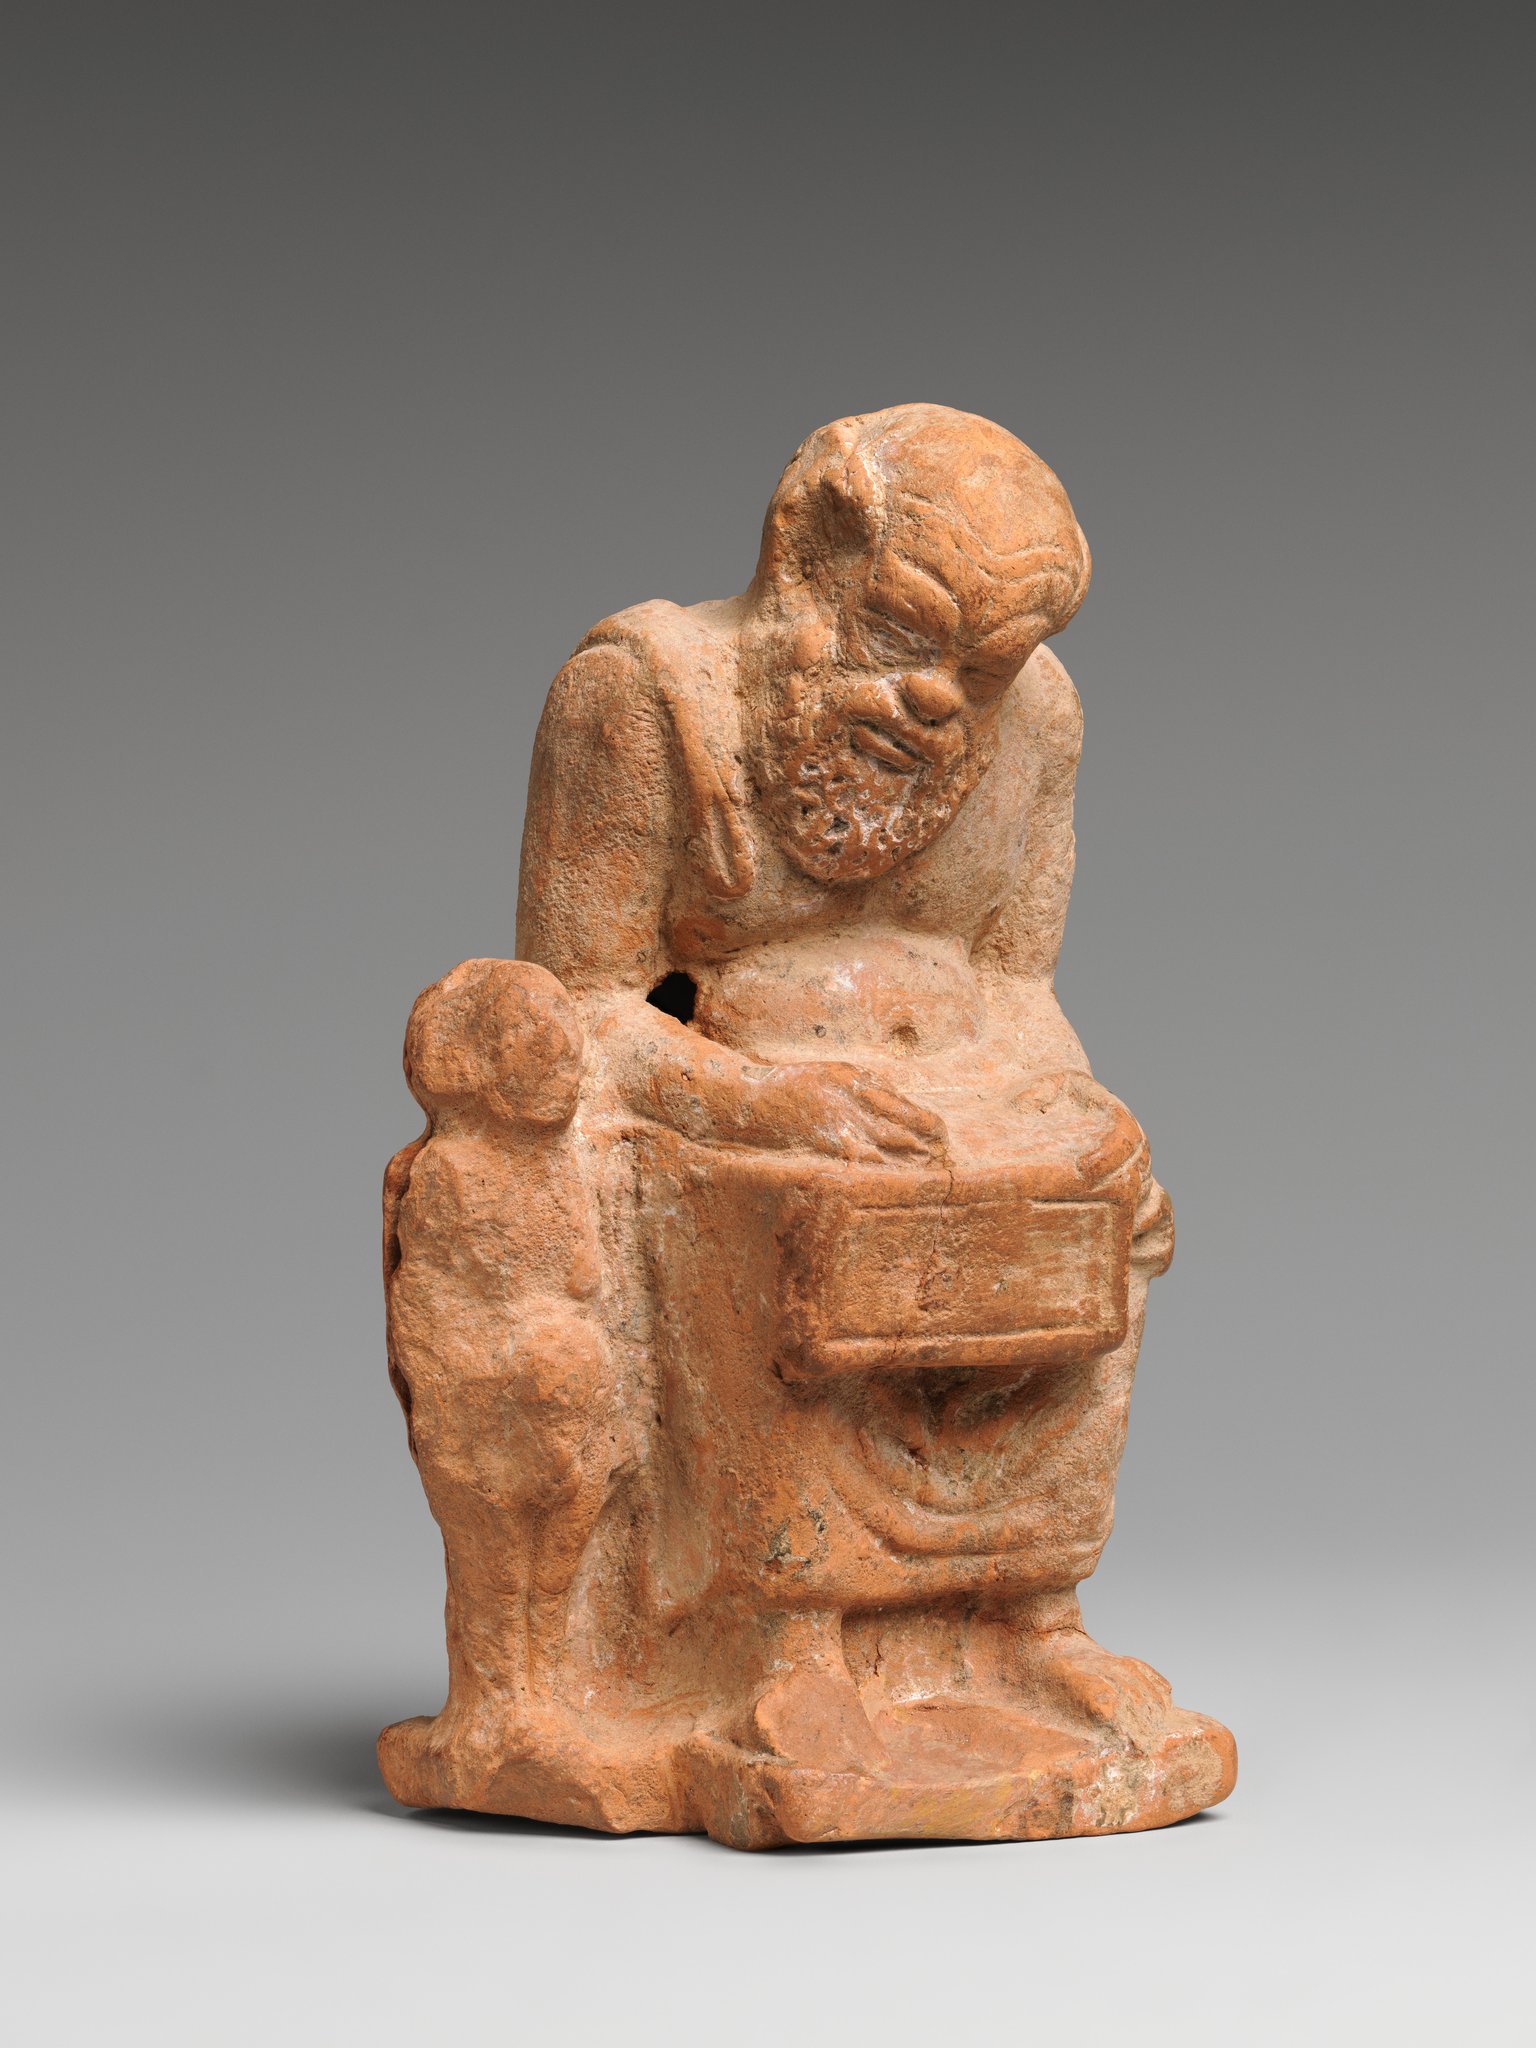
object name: statuette of a teacher and a pupil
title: Terracotta statuette of a teacher and a pupil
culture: greek, asia minor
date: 334-268 BCE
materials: terracotta